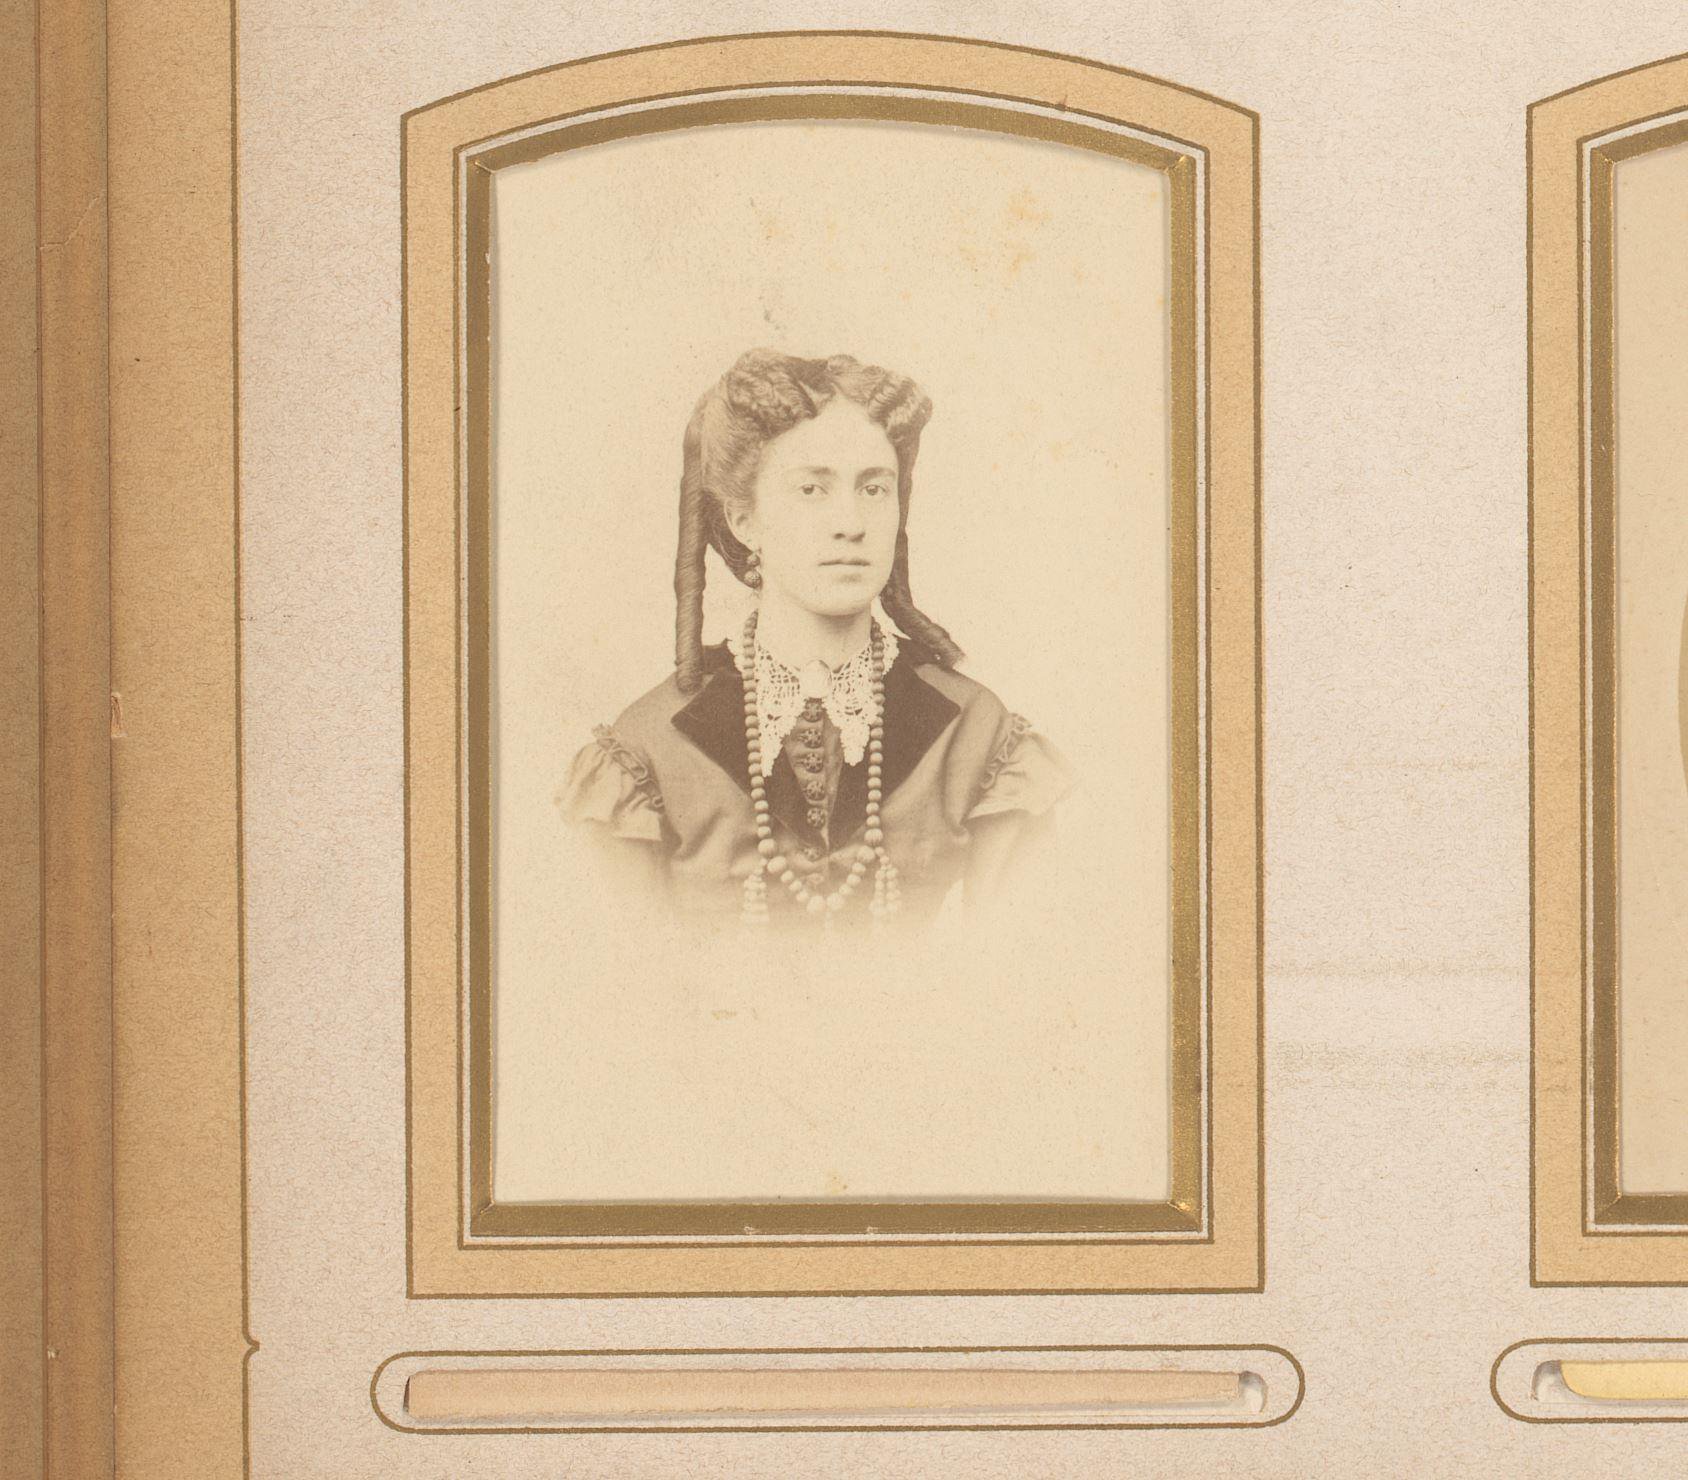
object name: album leaf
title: Portret van een vrouw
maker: adolphe anjoux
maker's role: fotograaf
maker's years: 1817-1889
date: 1870-1900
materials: cardboard, photographic support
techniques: albumen print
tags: adult woman, historical persons